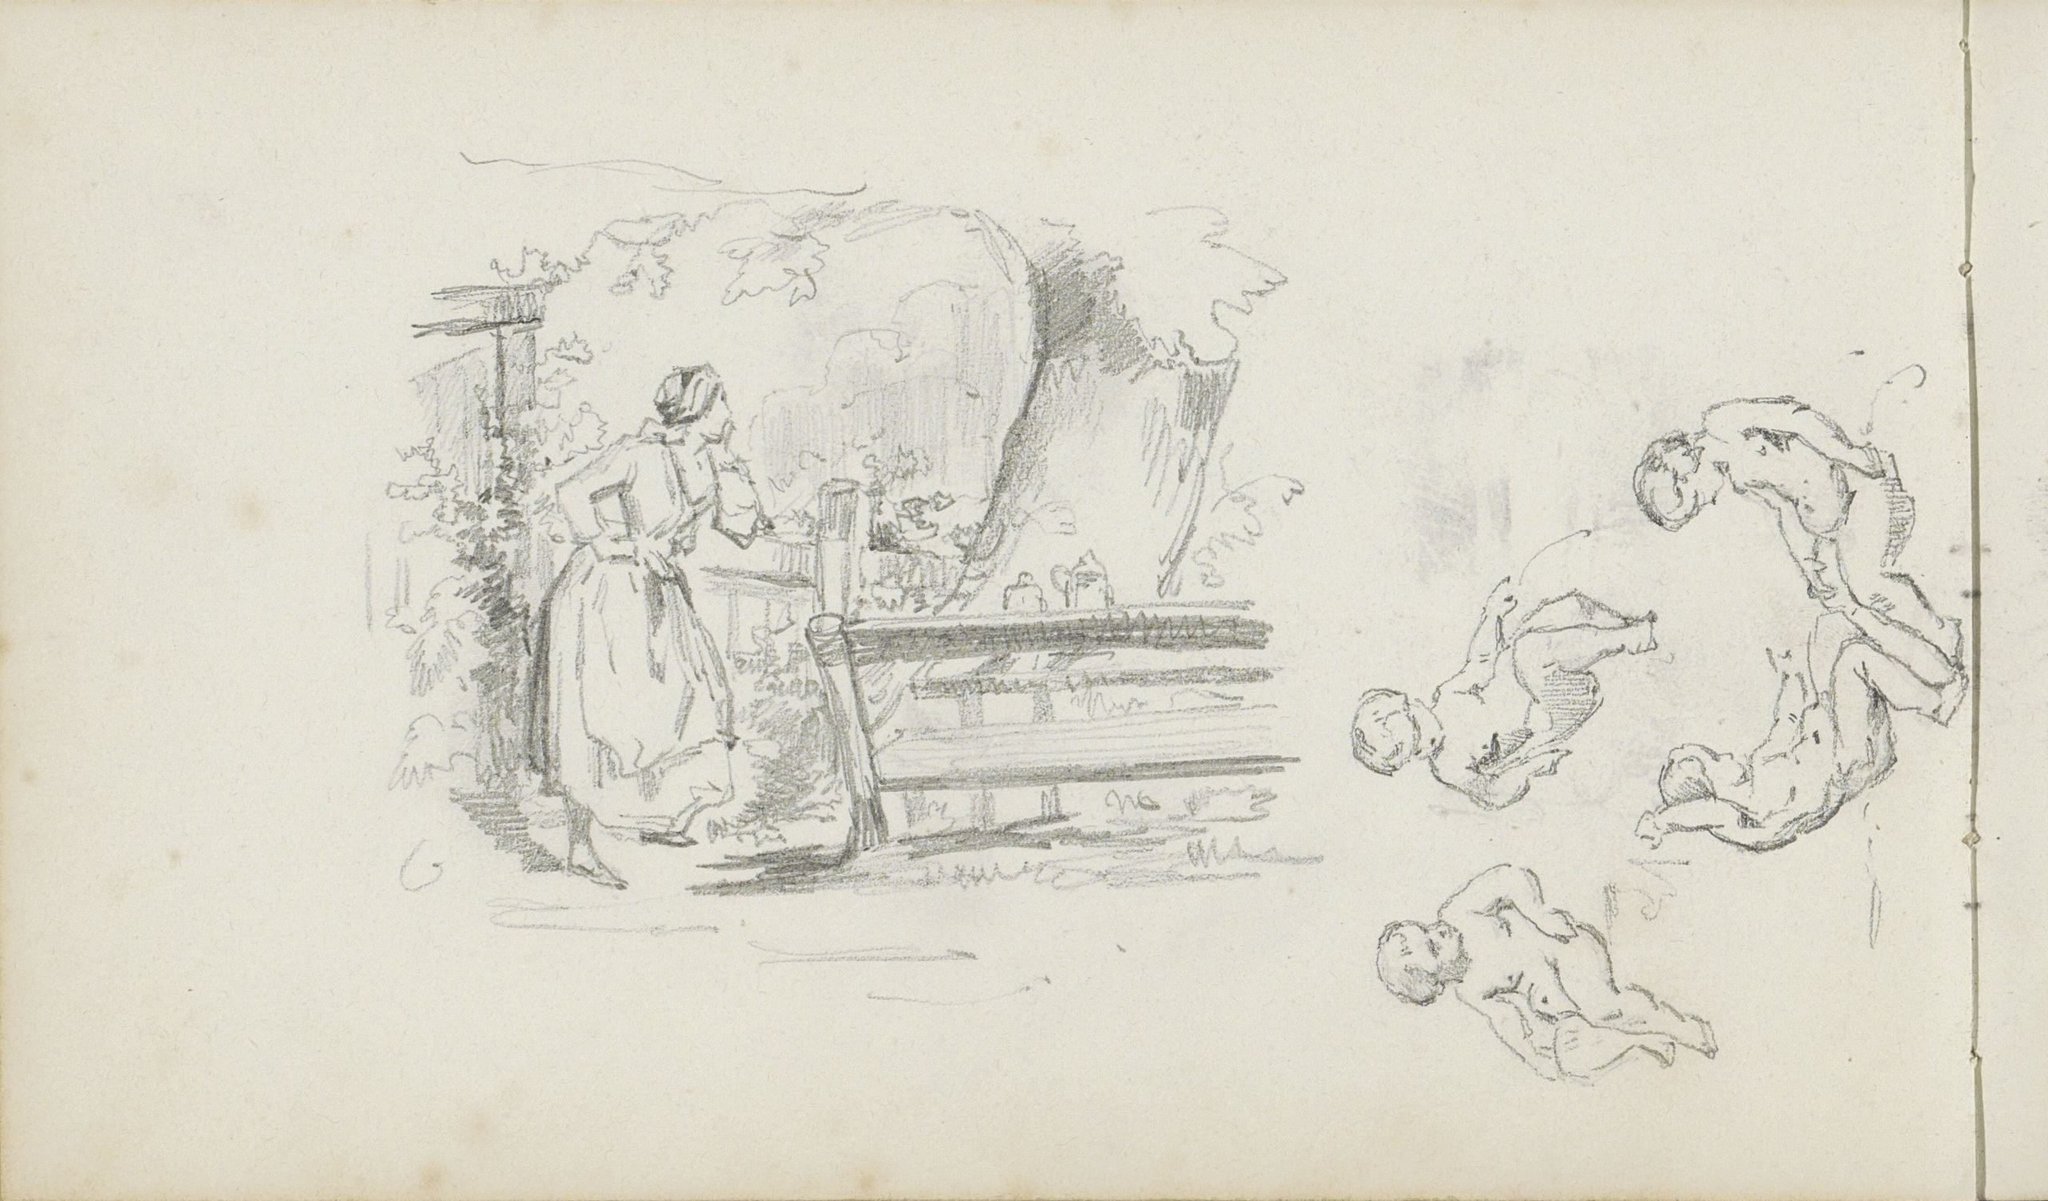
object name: sketchbook leaf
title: Vrouw leunend op een hek en putti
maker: charles rochussen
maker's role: draughtsman, painter, print maker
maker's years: 1814-1894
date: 1840-1860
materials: paper, pencil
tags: fence, wall, paling, standing figure - aa - female human figure, cupids: 'amores', 'amoretti', 'putti'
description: Blad 15 verso uit een schetsboek met 38 bladen.